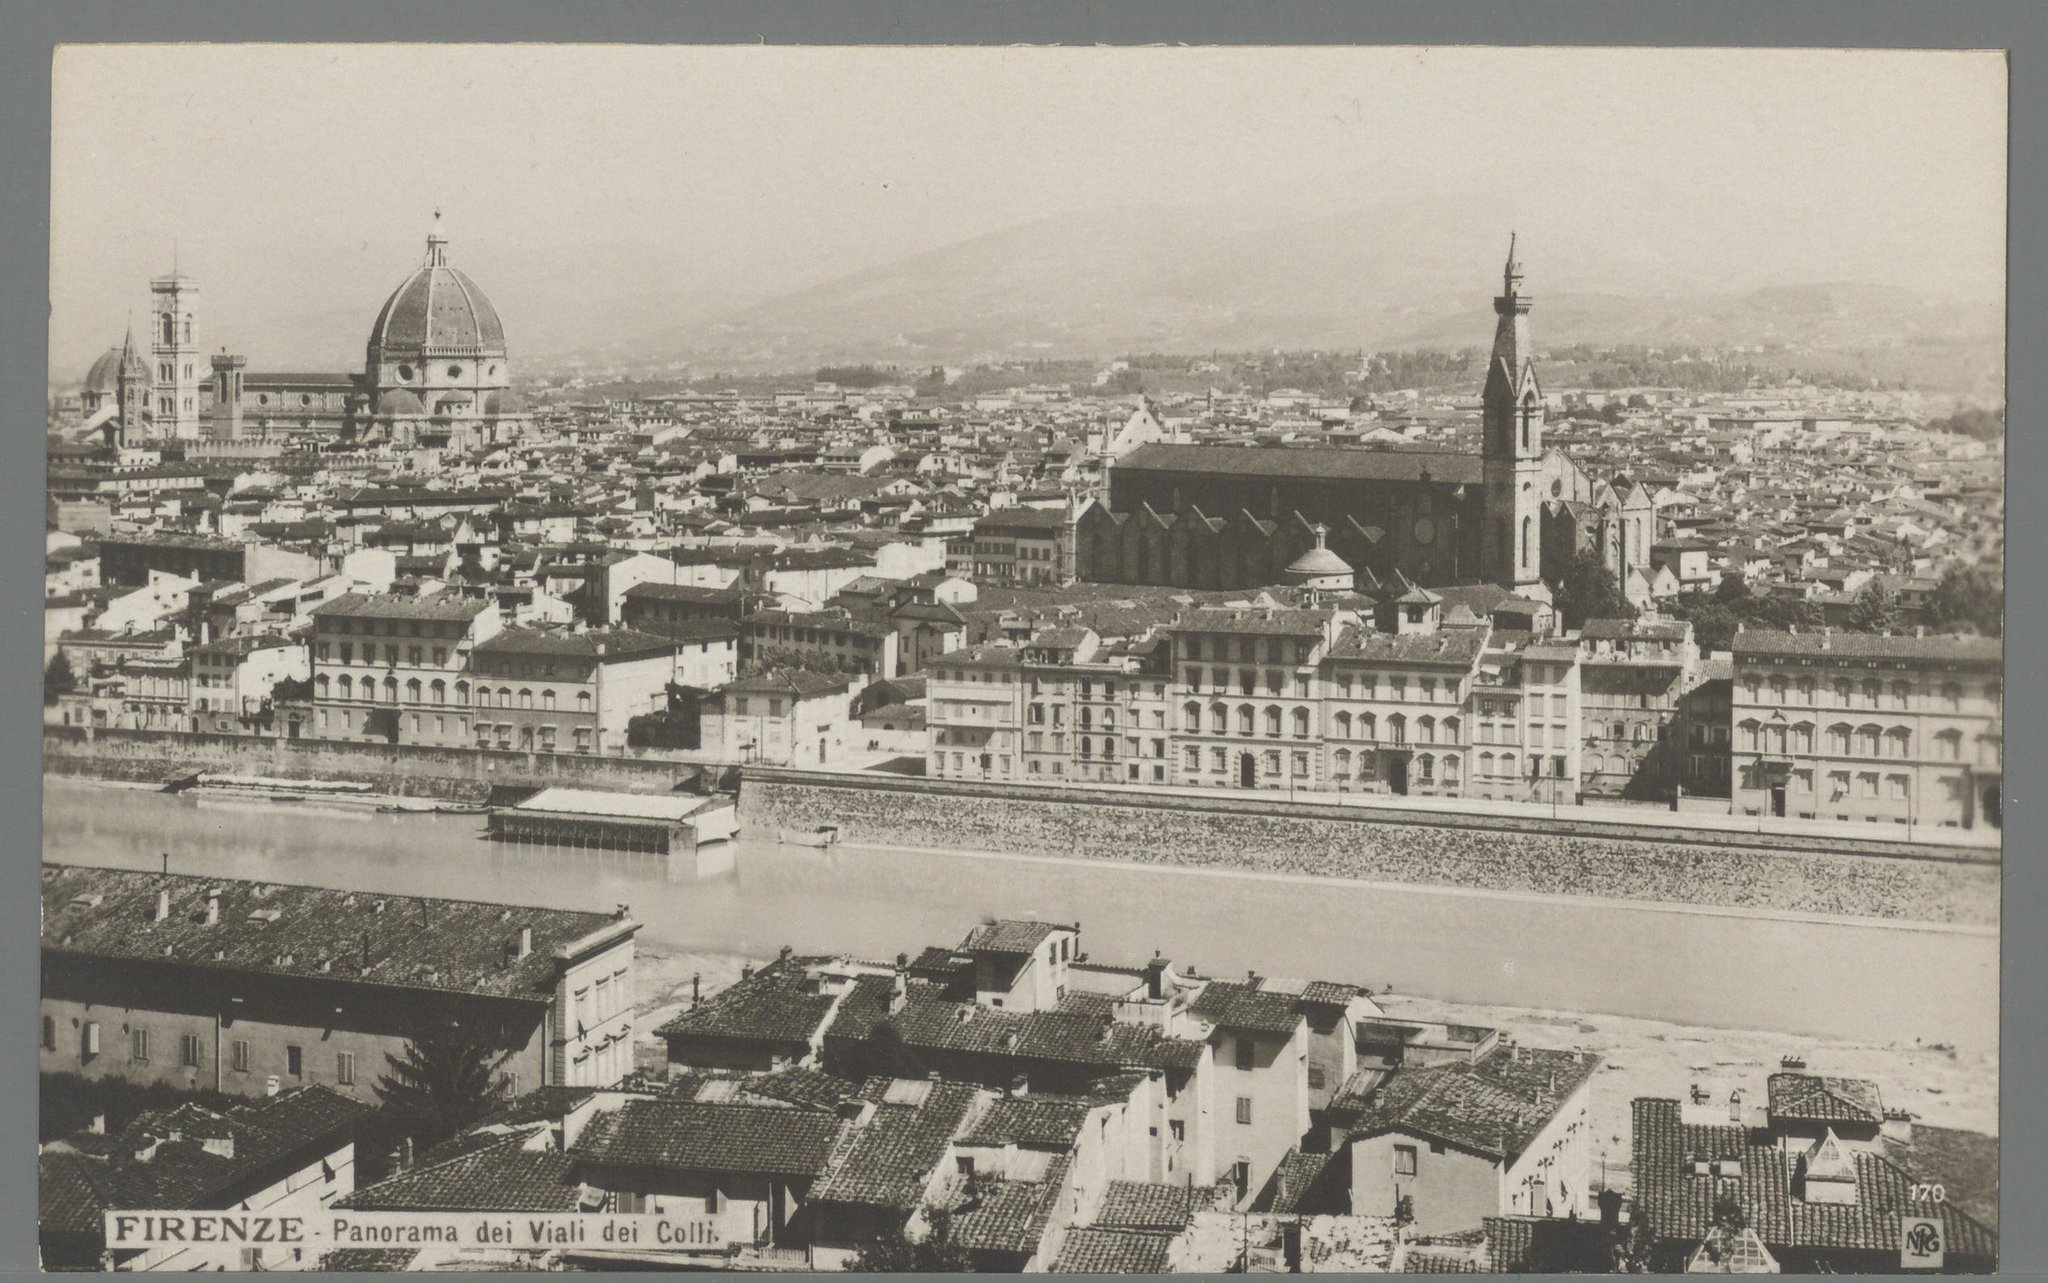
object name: ansichtkaart, prentbriefkaart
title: Firenze. Panorama dei Viali dei Colli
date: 1906-1920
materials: paper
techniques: gelatin silver print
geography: florence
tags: river, church (exterior)